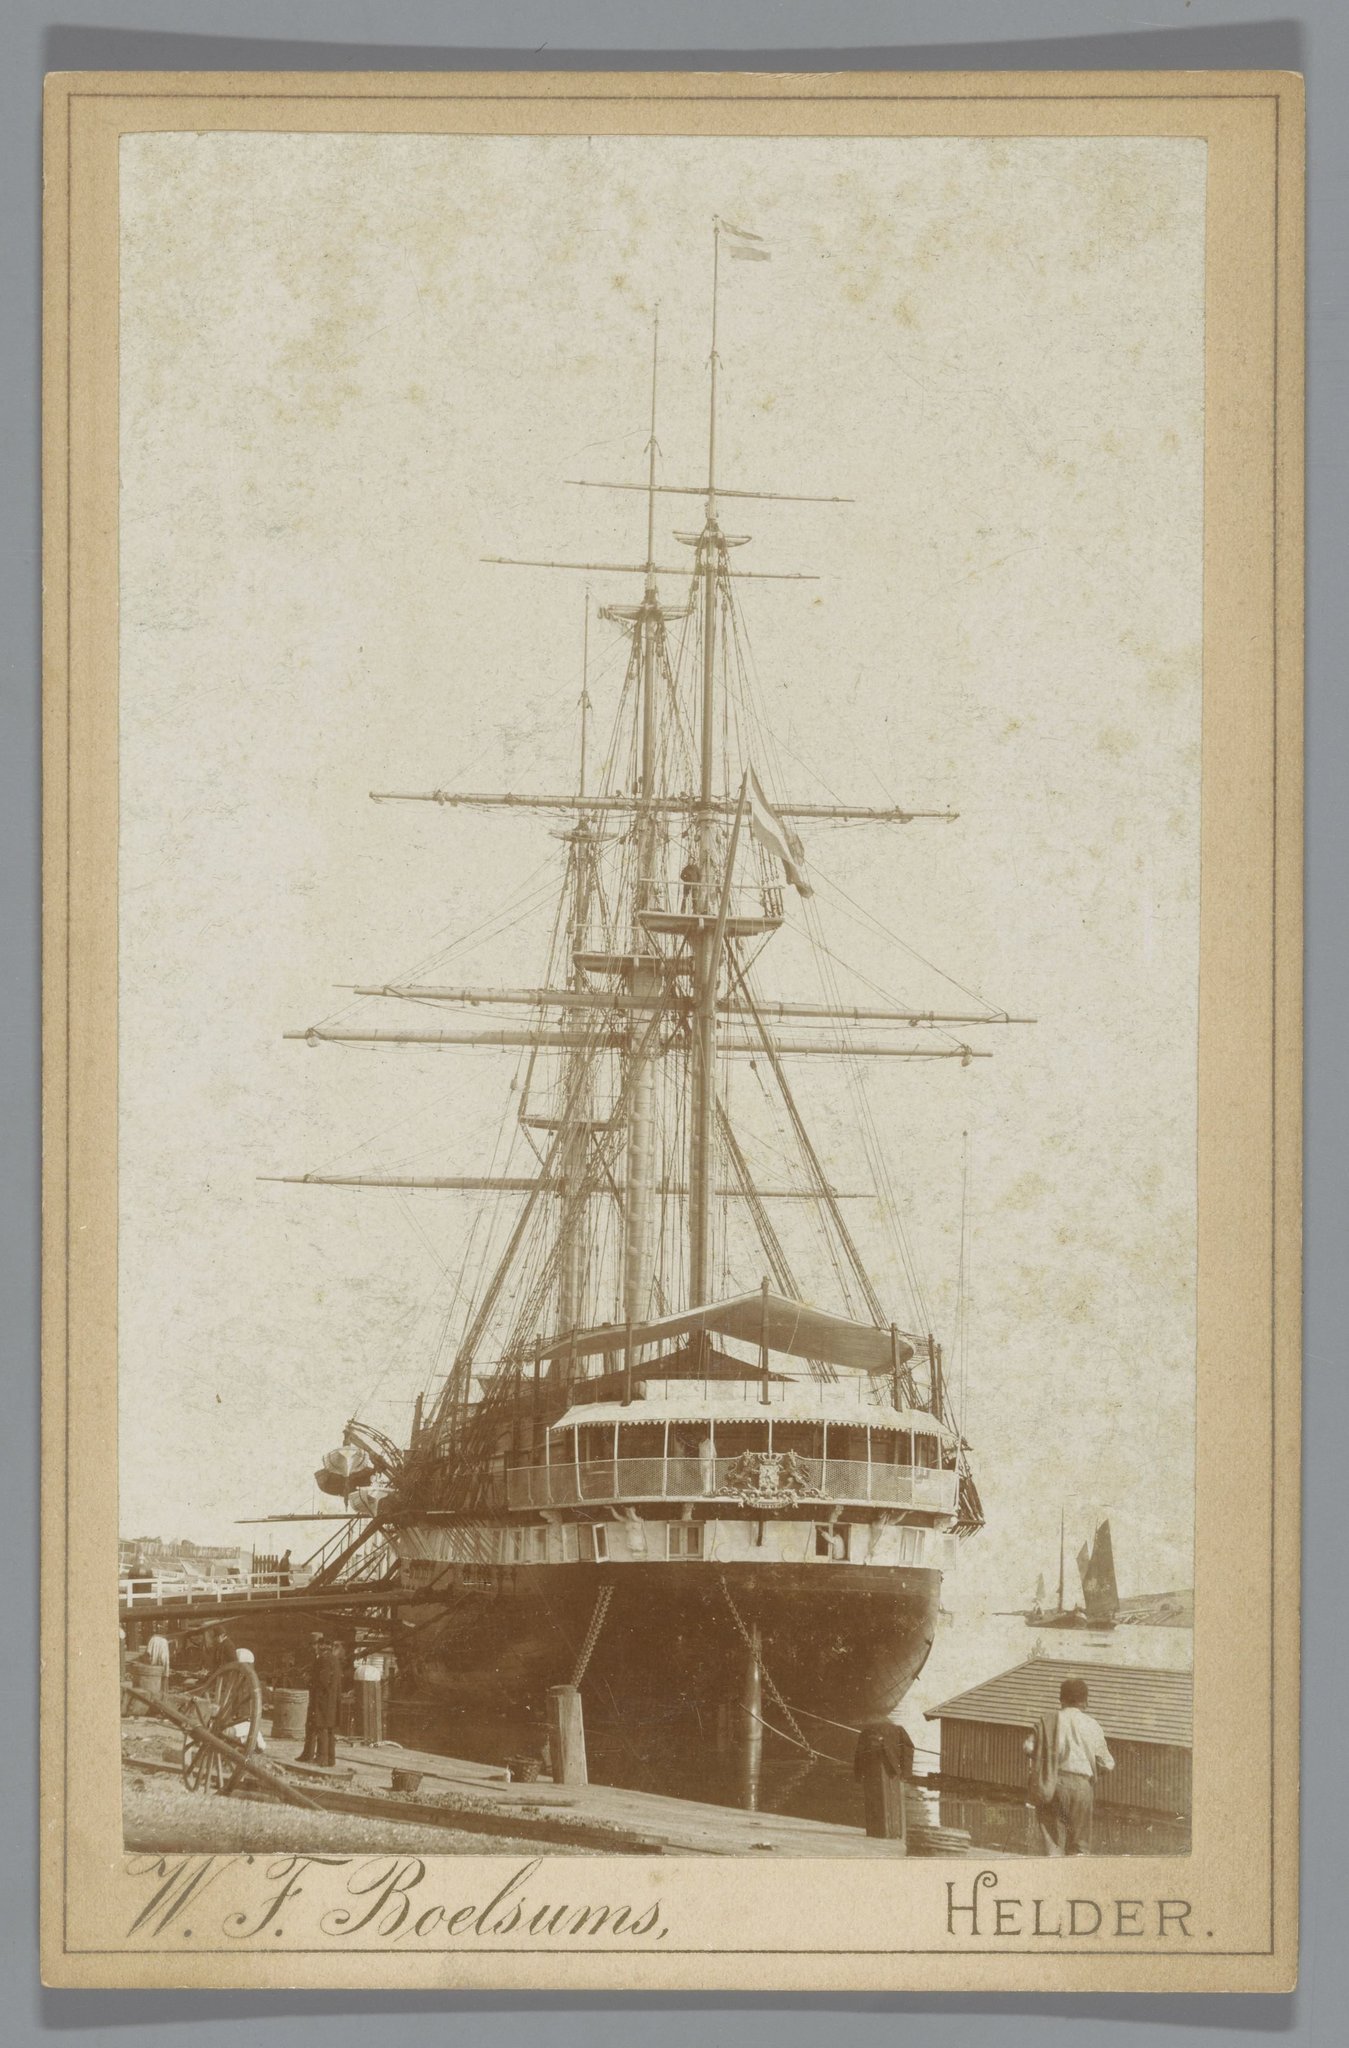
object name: cabinet photograph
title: Kl. fregat. Wachtschip Helder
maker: willem frederik boelsums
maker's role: fotograaf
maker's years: 1851-1907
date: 1890-1903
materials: paper, cardboard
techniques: collodion silver print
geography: den helder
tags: sailing-ship, sailing-boat, navy, den helder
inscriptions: inscription: ‘Photographie instantanée/ W.F. Boelsums (...) De plaat blijft voor nabestelling bewaard.’, collector's mark: ‘Vosmaer’